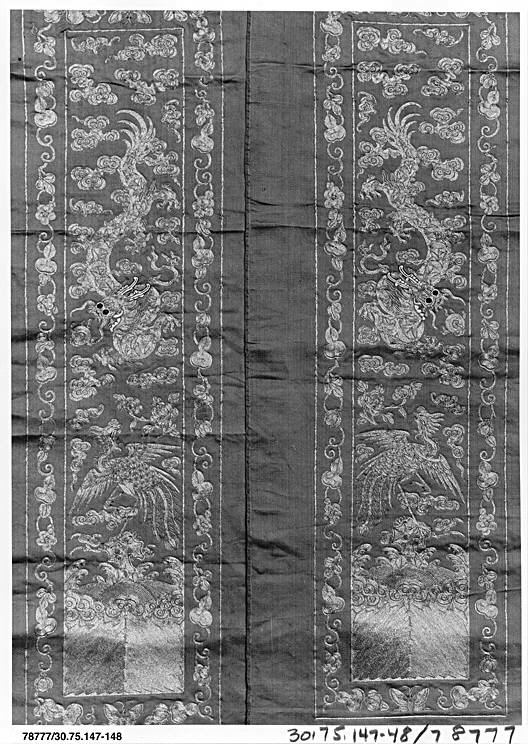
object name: sleeve band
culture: chinese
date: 1801-1900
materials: metal thread, silk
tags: dragons